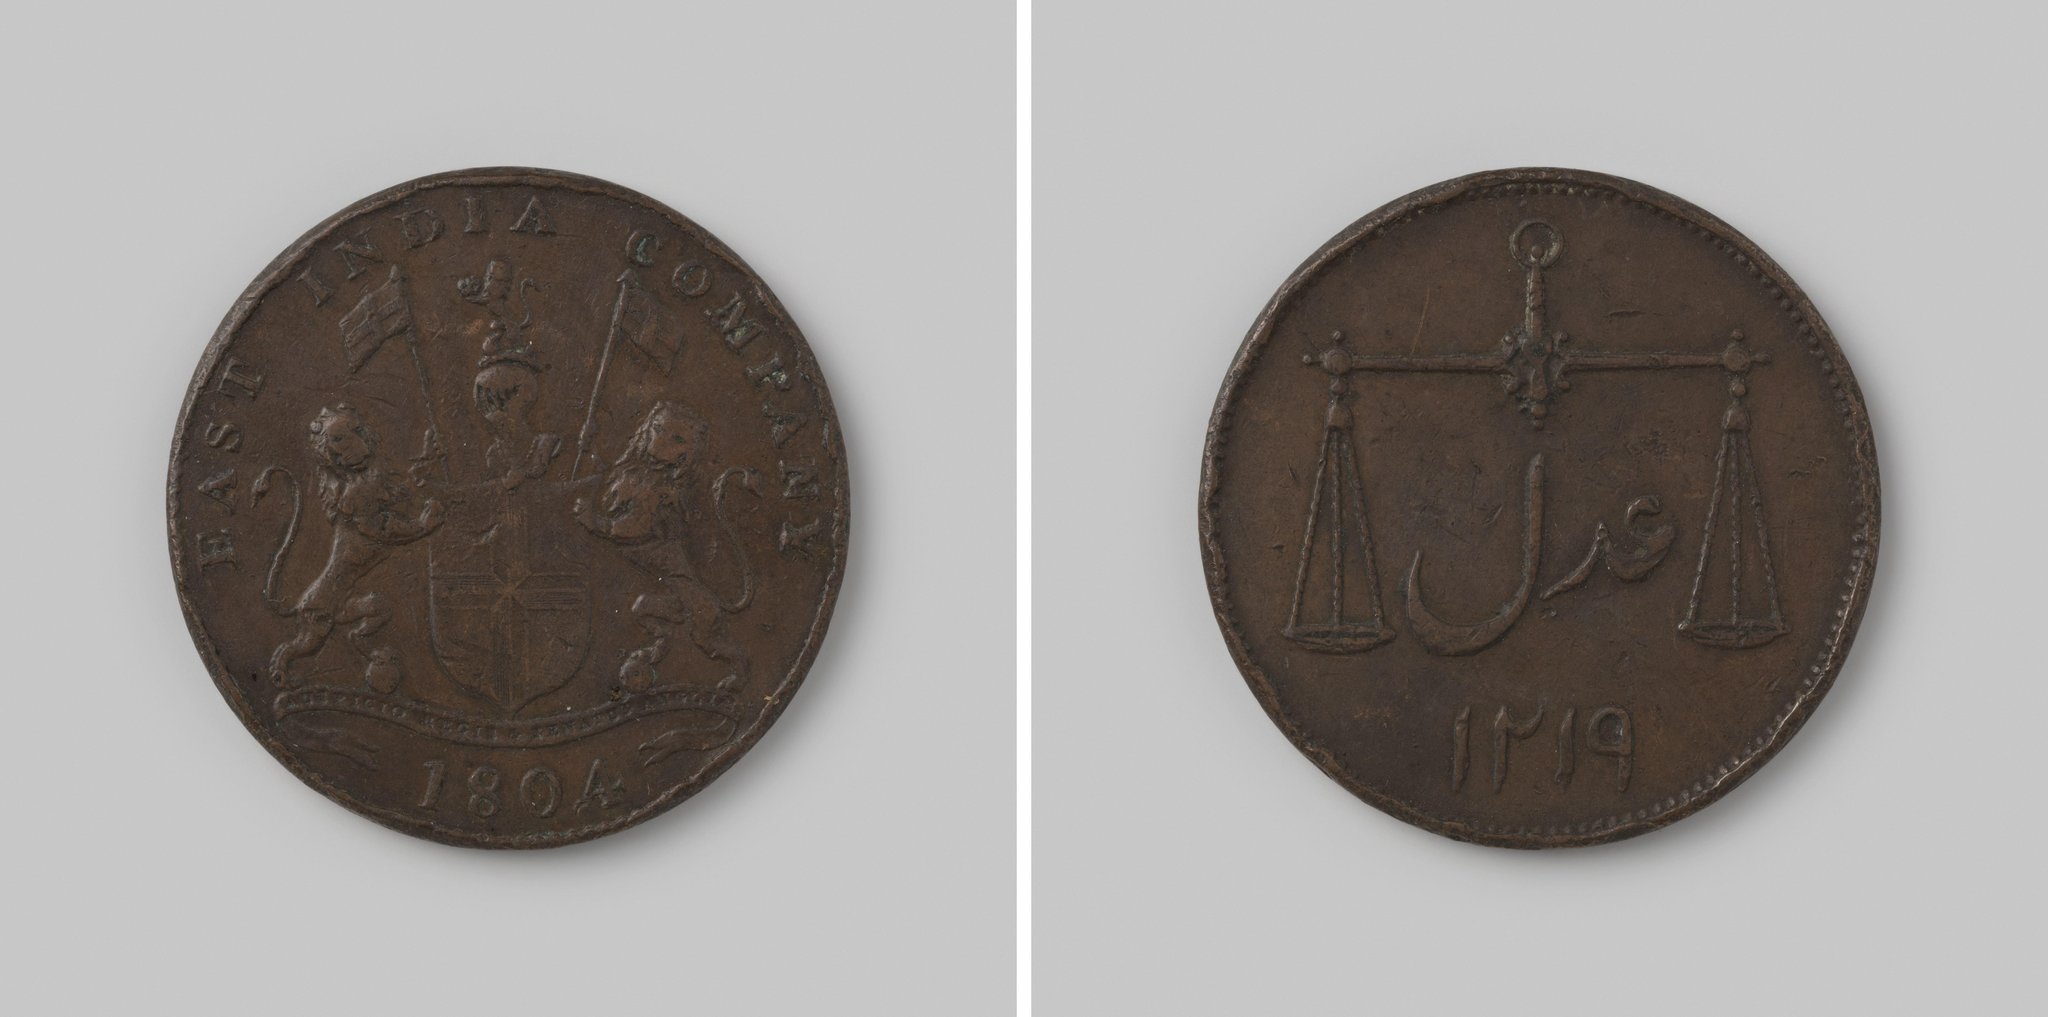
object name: coin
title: Bombay, India, Engelse Oostindische Compagnie (EIC) , 2 pice voor Bombay, India, 1219, 1804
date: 1804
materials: copper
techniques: striking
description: Koperen munt. Voorzijde: door twee op banderol, waarin opschrift, staande leeuwen met pijl, waaraan vlag, in de klauw, gehouden wapenschild van de EIC, waarboven helmteken. Jaartal onderaan. Keerzijde: weegschaal, waartussen in Arabische lettertekens opschrift: Adil en waaronder jaartal: 1219 [=1804]. Gladde rand. Geslagen in Engeland.